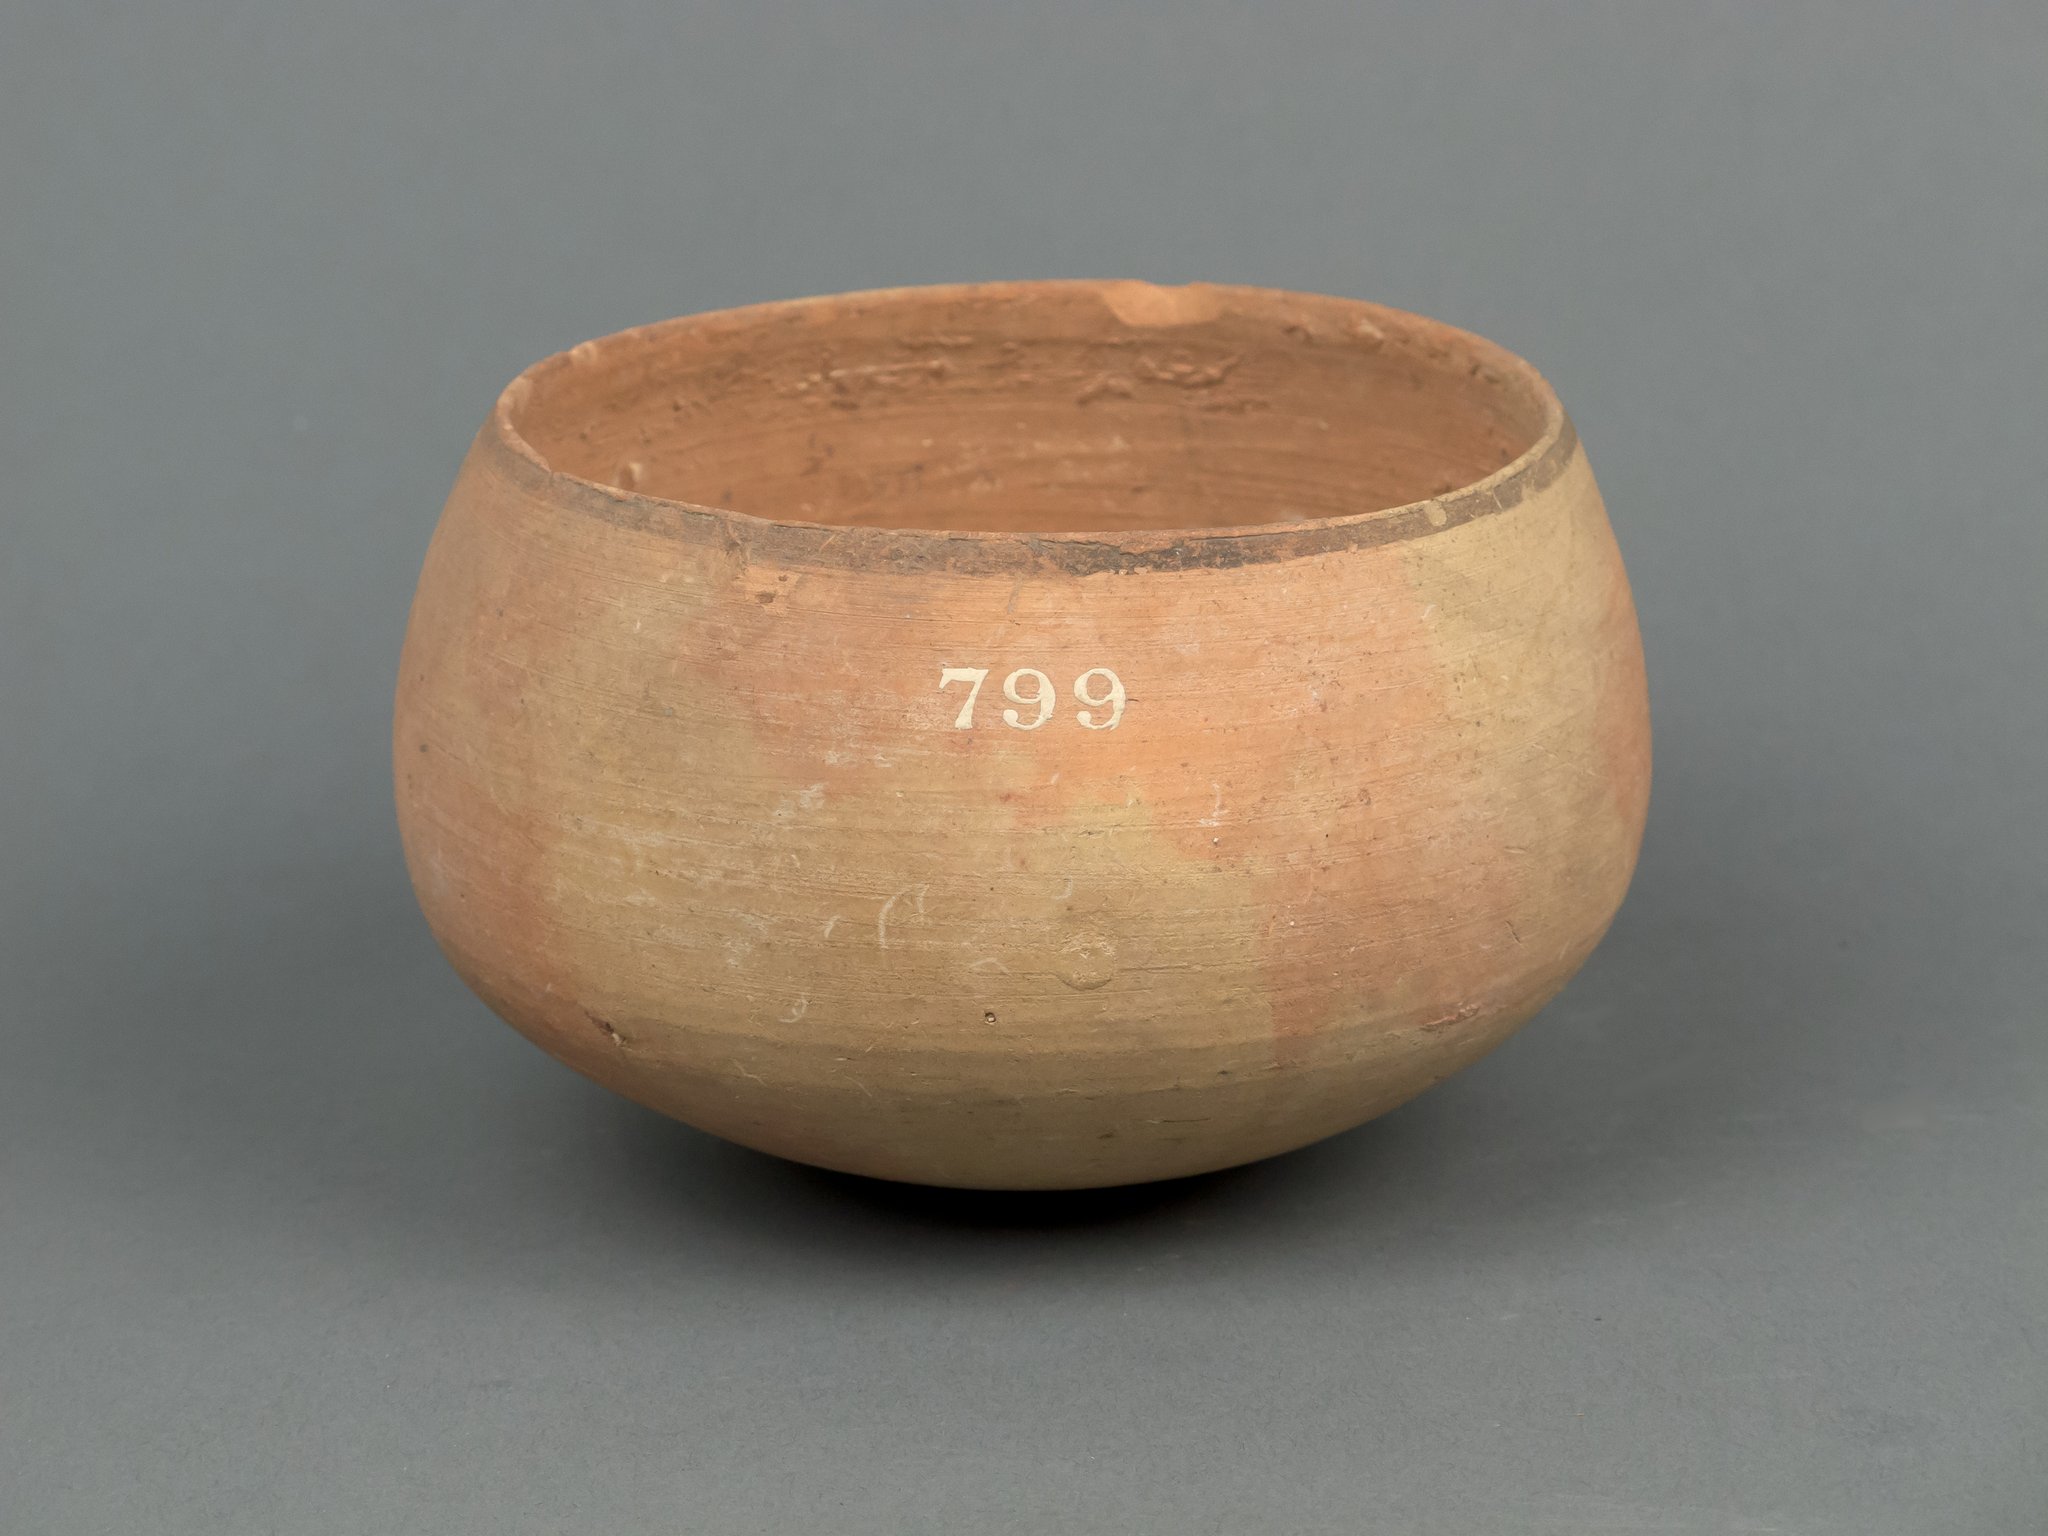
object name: bowl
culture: cypriot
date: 750-600 BCE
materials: terracotta